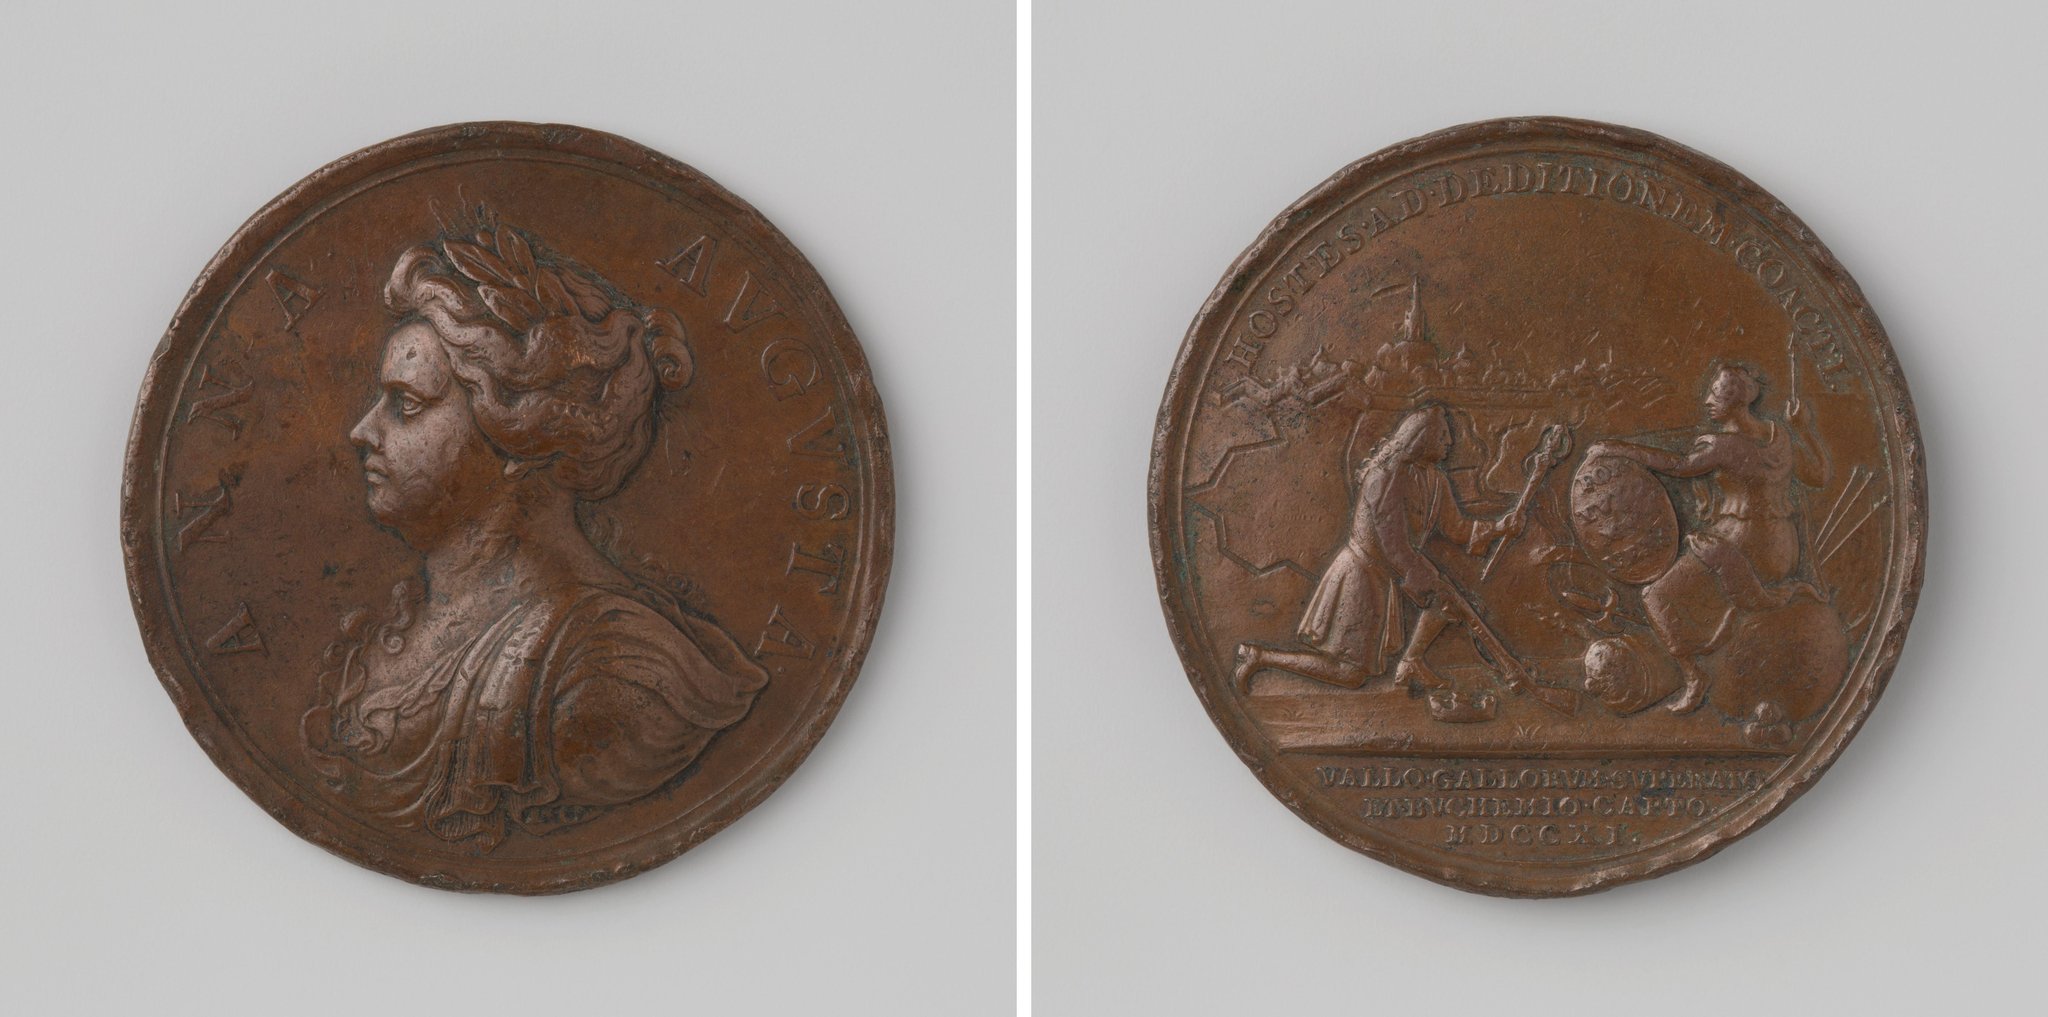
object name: history medal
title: Overmeestering van de Franse linies en inname van Bouchain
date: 1711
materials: bronze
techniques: striking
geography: london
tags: london, anna stuart (koningin van engeland en schotland)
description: Bronzen penning. Voorzijde: borststuk vrouw met lauwerkrans binnen omschrift. Keerzijde: knielende Franse soldaat overhandigt zijn zwaard, geweer en kroon aan vrouw met speer en schild in handen, zittend op wereldbol temidden van stapel wapentuig, op achtergrond de veroverde stad binnen omschrift; afsnede: opschrift.